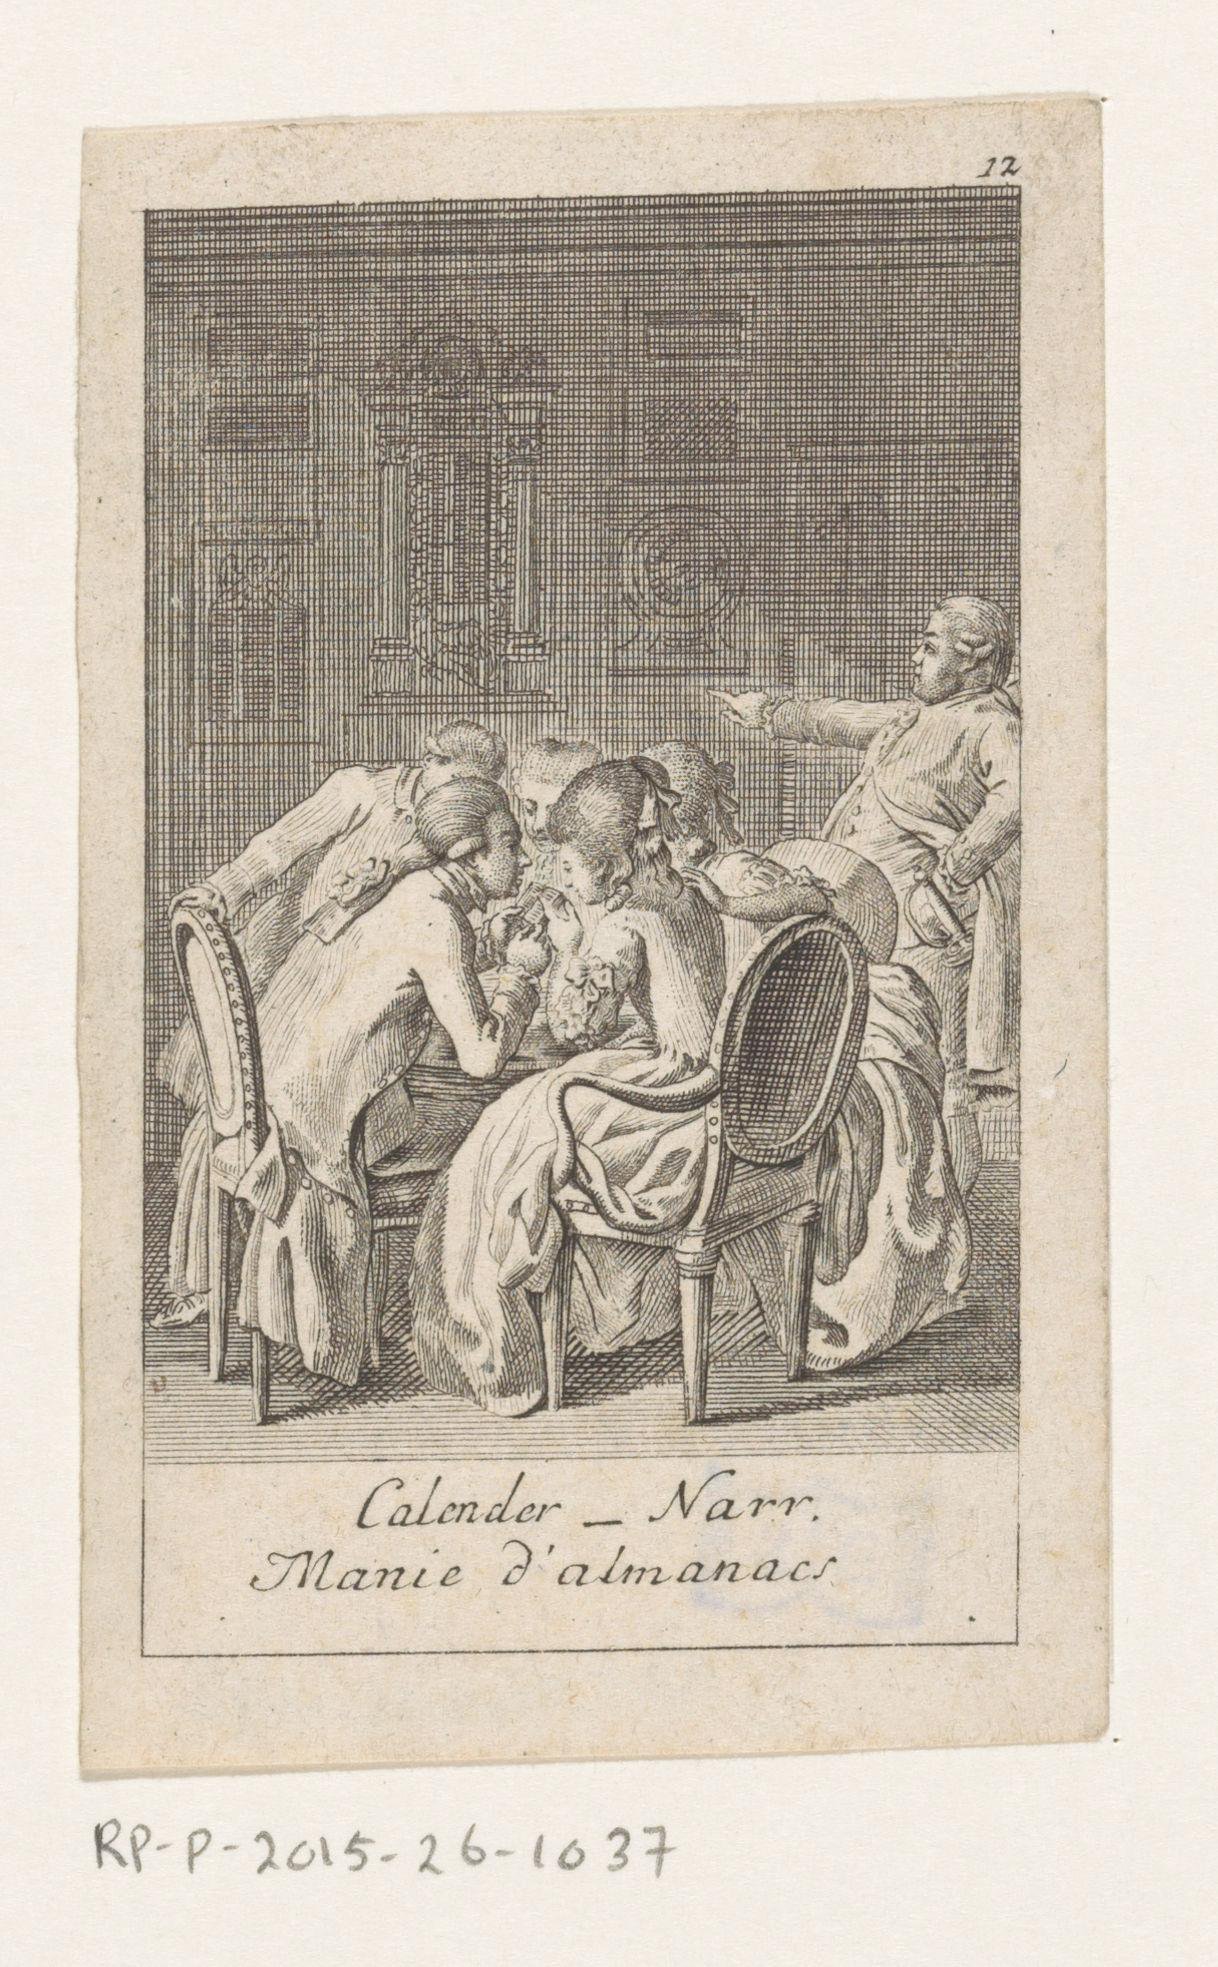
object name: print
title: Centifolium stultorum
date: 1782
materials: paper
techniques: etching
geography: gottingen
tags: calendar, almanac, newspaper, news-sheet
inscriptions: collector's mark: Lugt 2228, collector's mark: Lugt 4779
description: Prent afkomstig uit: Göttingischer Taschen-Calender vom Jahr 1783. Göttingen, Johann Christian Dieterich, [1782].